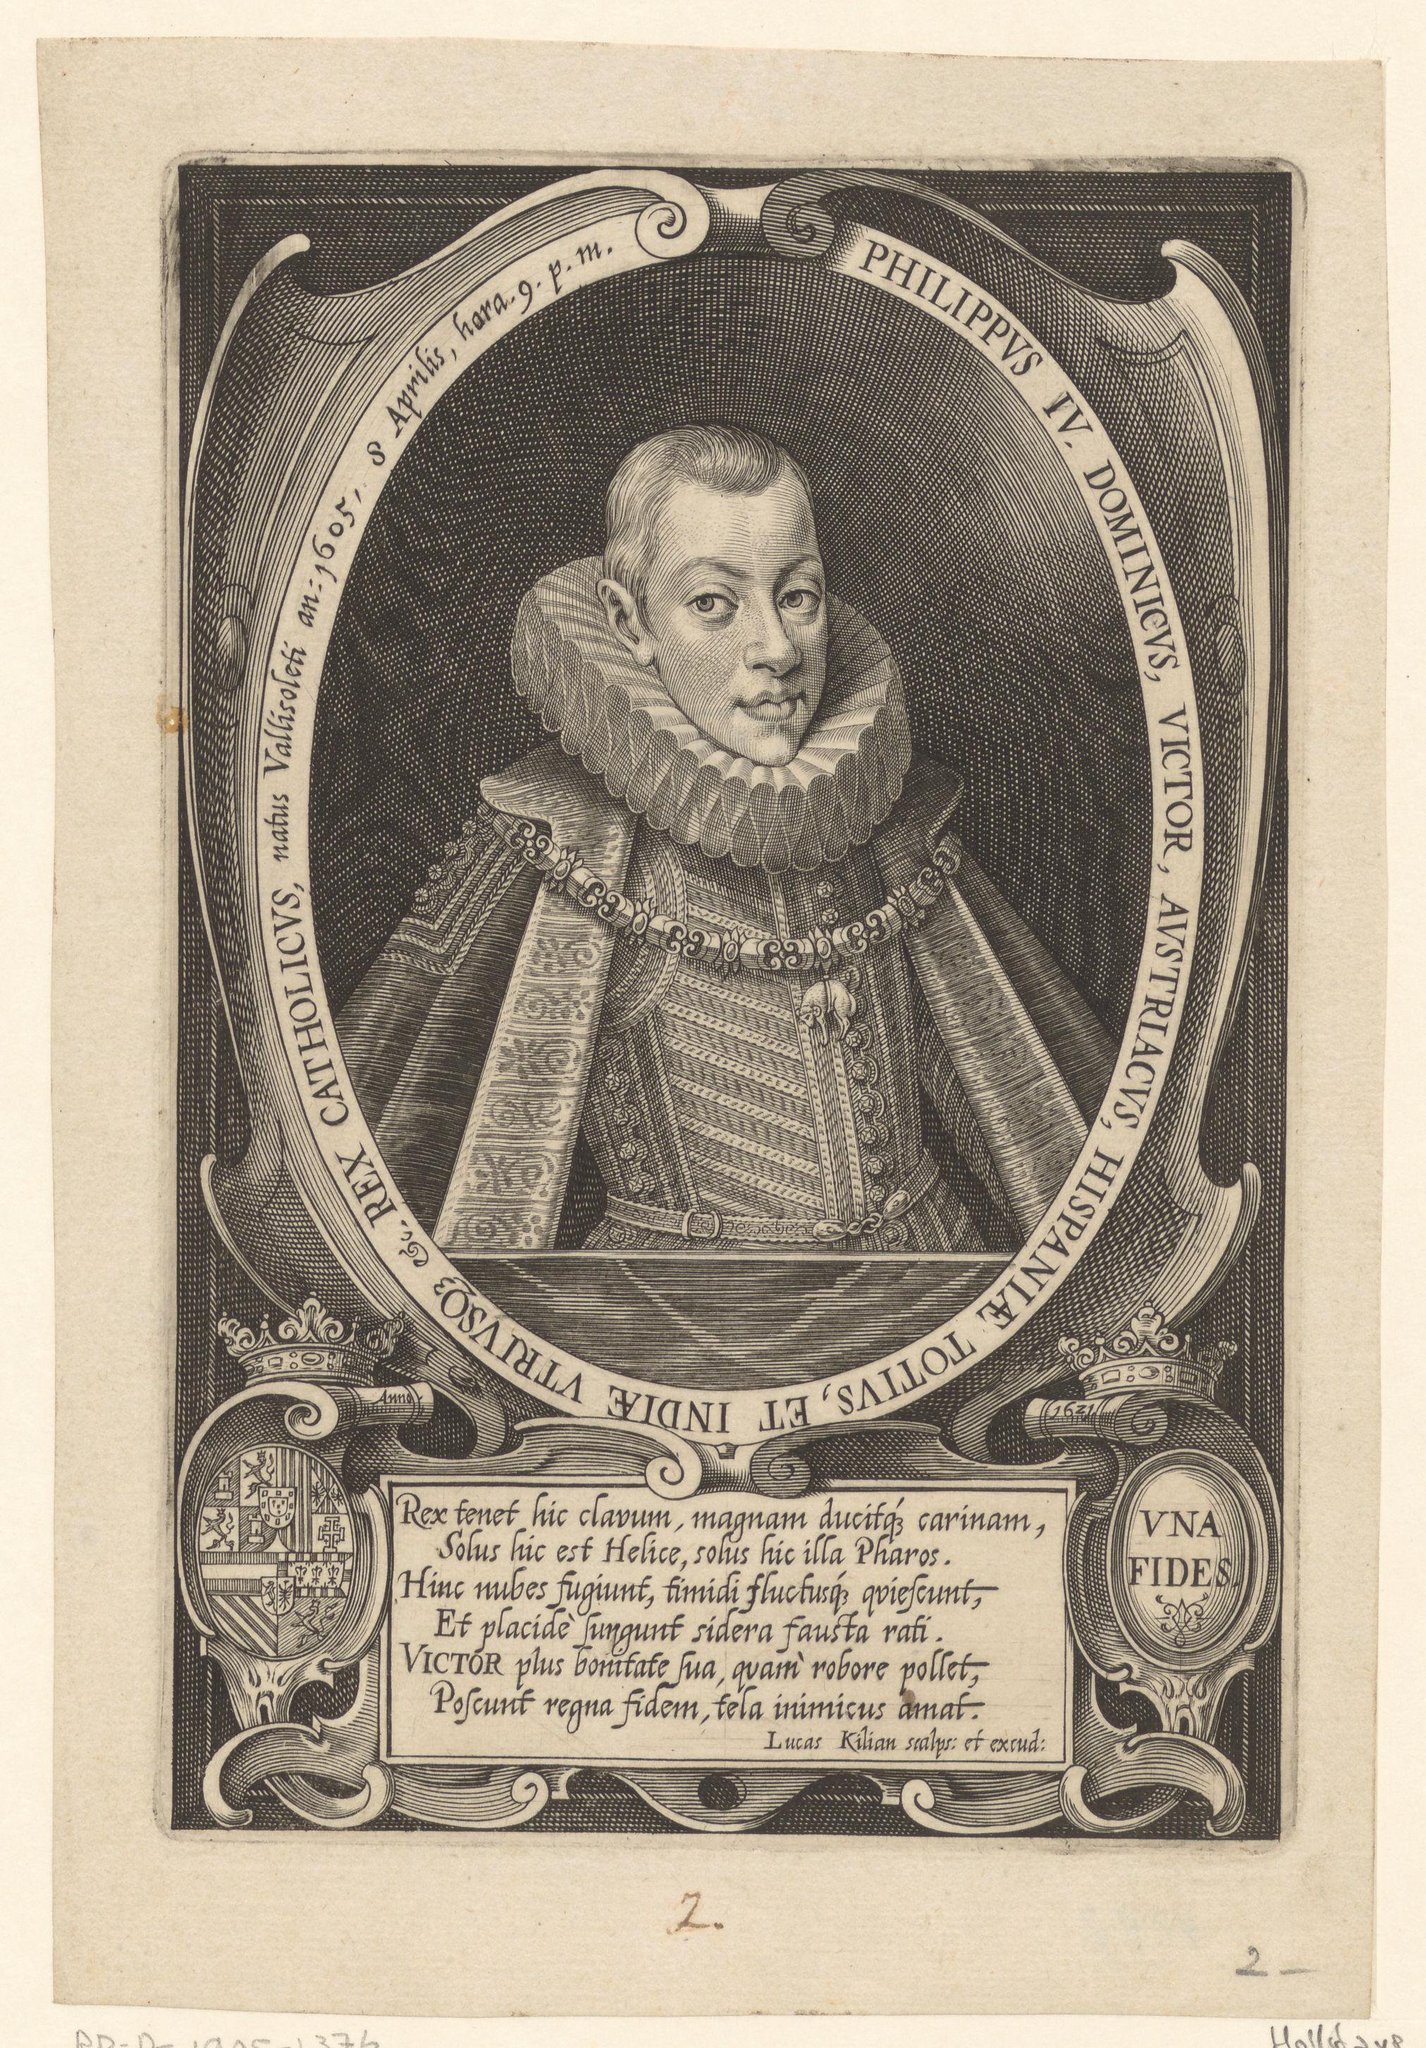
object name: print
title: Portret van Filips IV, koning van Napels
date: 1610-1624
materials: paper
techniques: engraving, etching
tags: filips iv (koning van spanje), historical persons, knighthood order of the golden fleece - insignia of a knighthood order, e.g.: badge, chain (with name of order), king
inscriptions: collector's mark: Lugt 2228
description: Deze prent is gebruikt in: Mazzella, Scipione, Kilian, Lucas en Custos, Dominicus. Der Neapolitanische Koenige Leben und Bildnisse (...). Augsburg: Lucas Kilian, 1624.